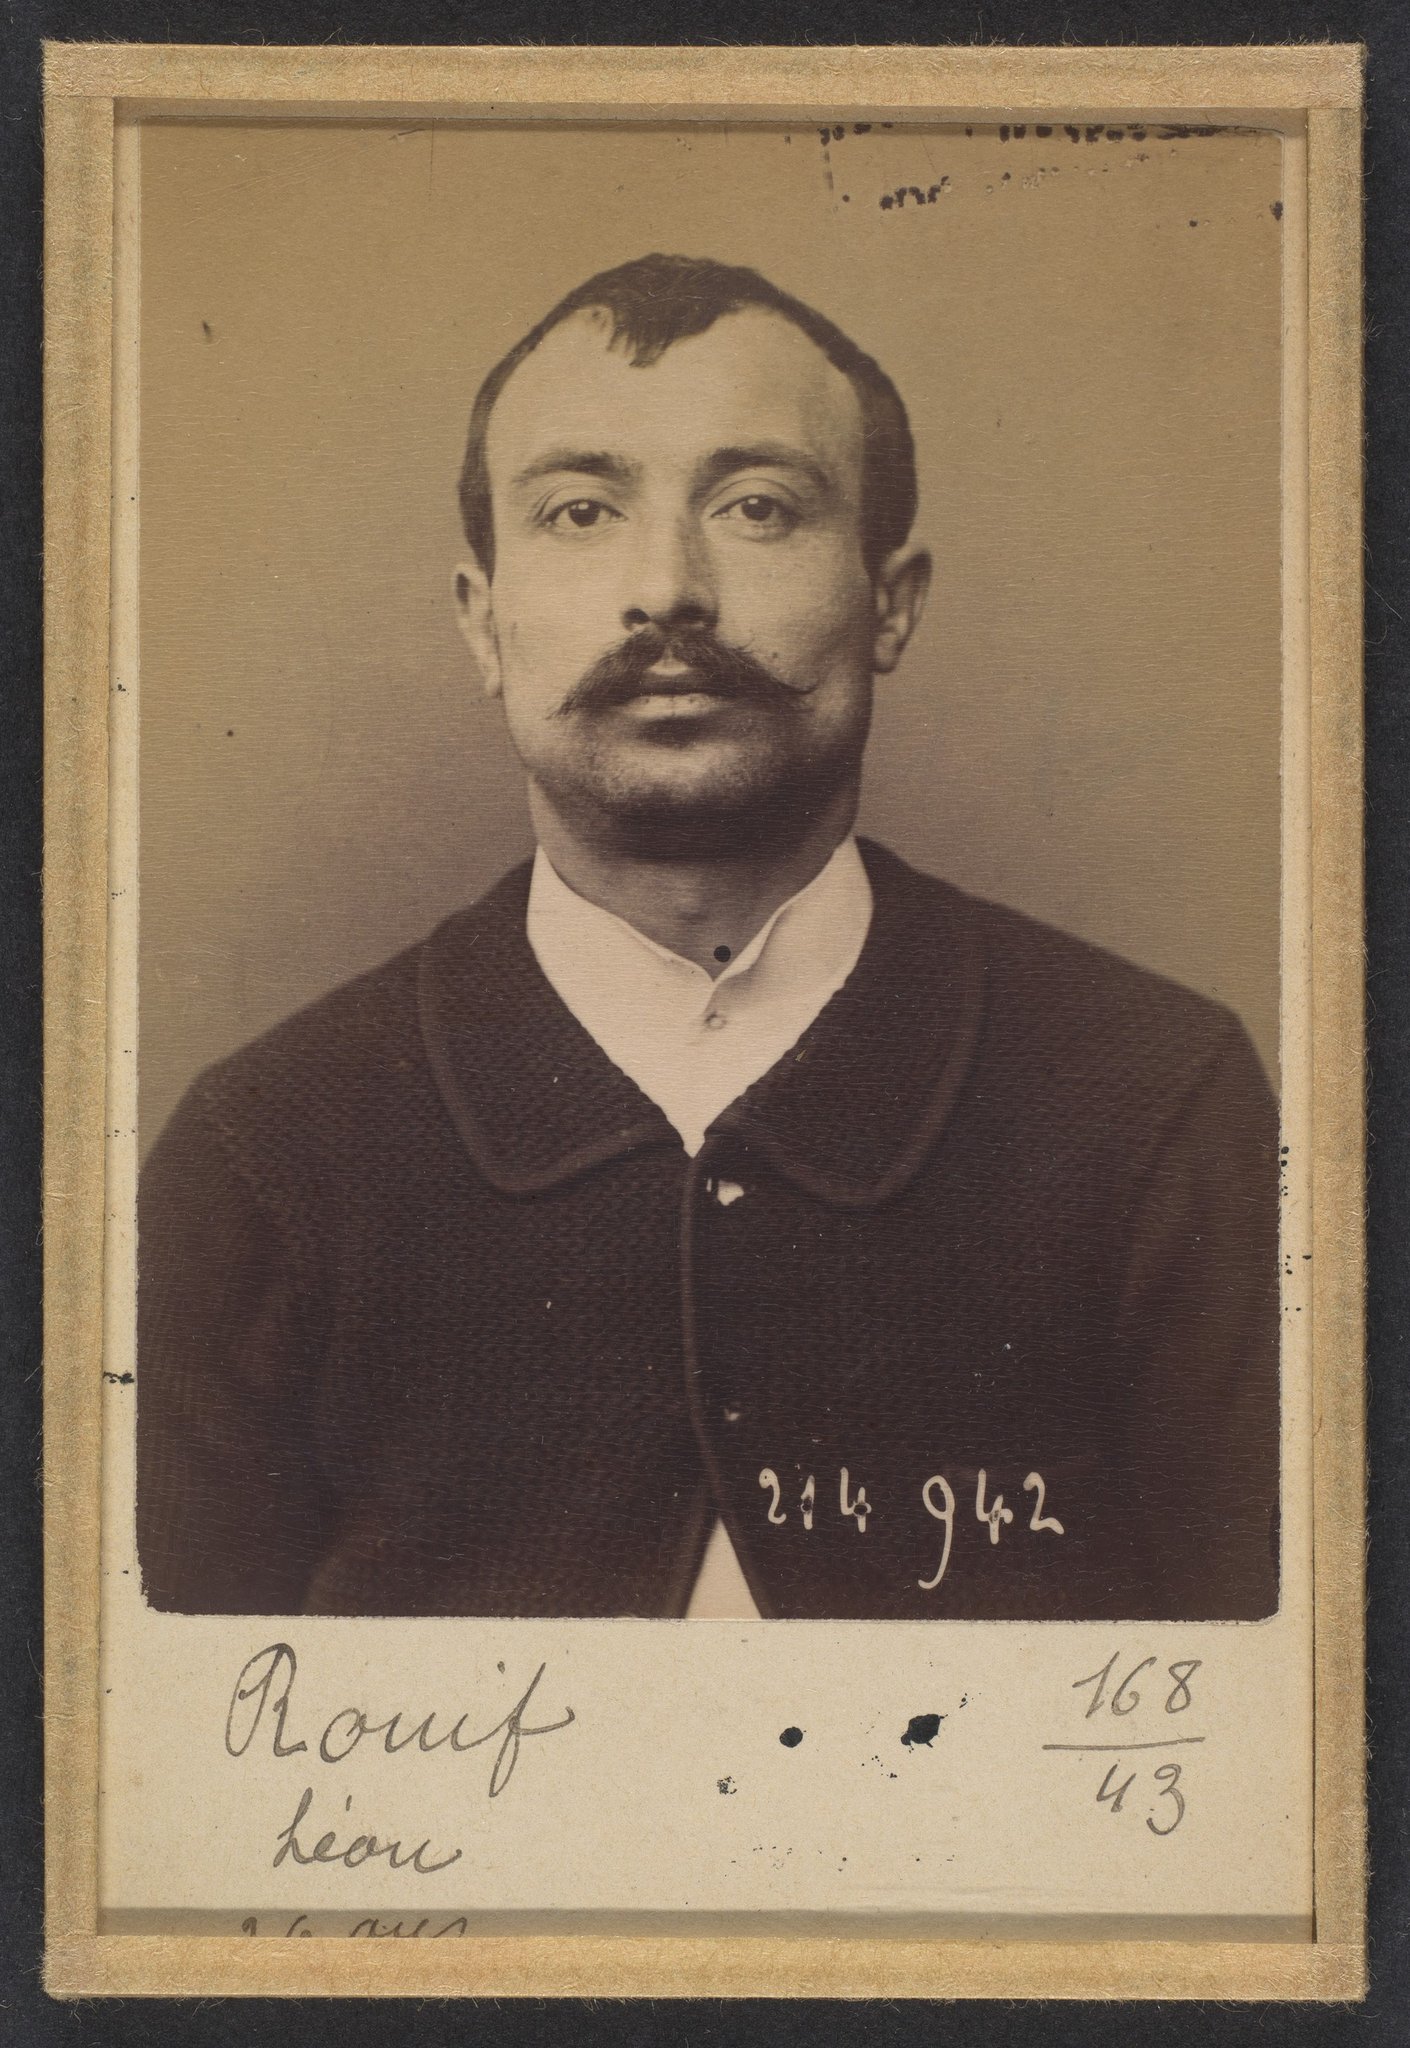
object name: mugshot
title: Rouif. Léon. 27 ans, né à Villethierry (Yonne). Garçon boucher. Anarchiste. 1/3/94.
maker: alphonse bertillon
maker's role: artist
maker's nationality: french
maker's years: 1853-1914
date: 1894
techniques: albumen silver print, glass negative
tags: men,portraits